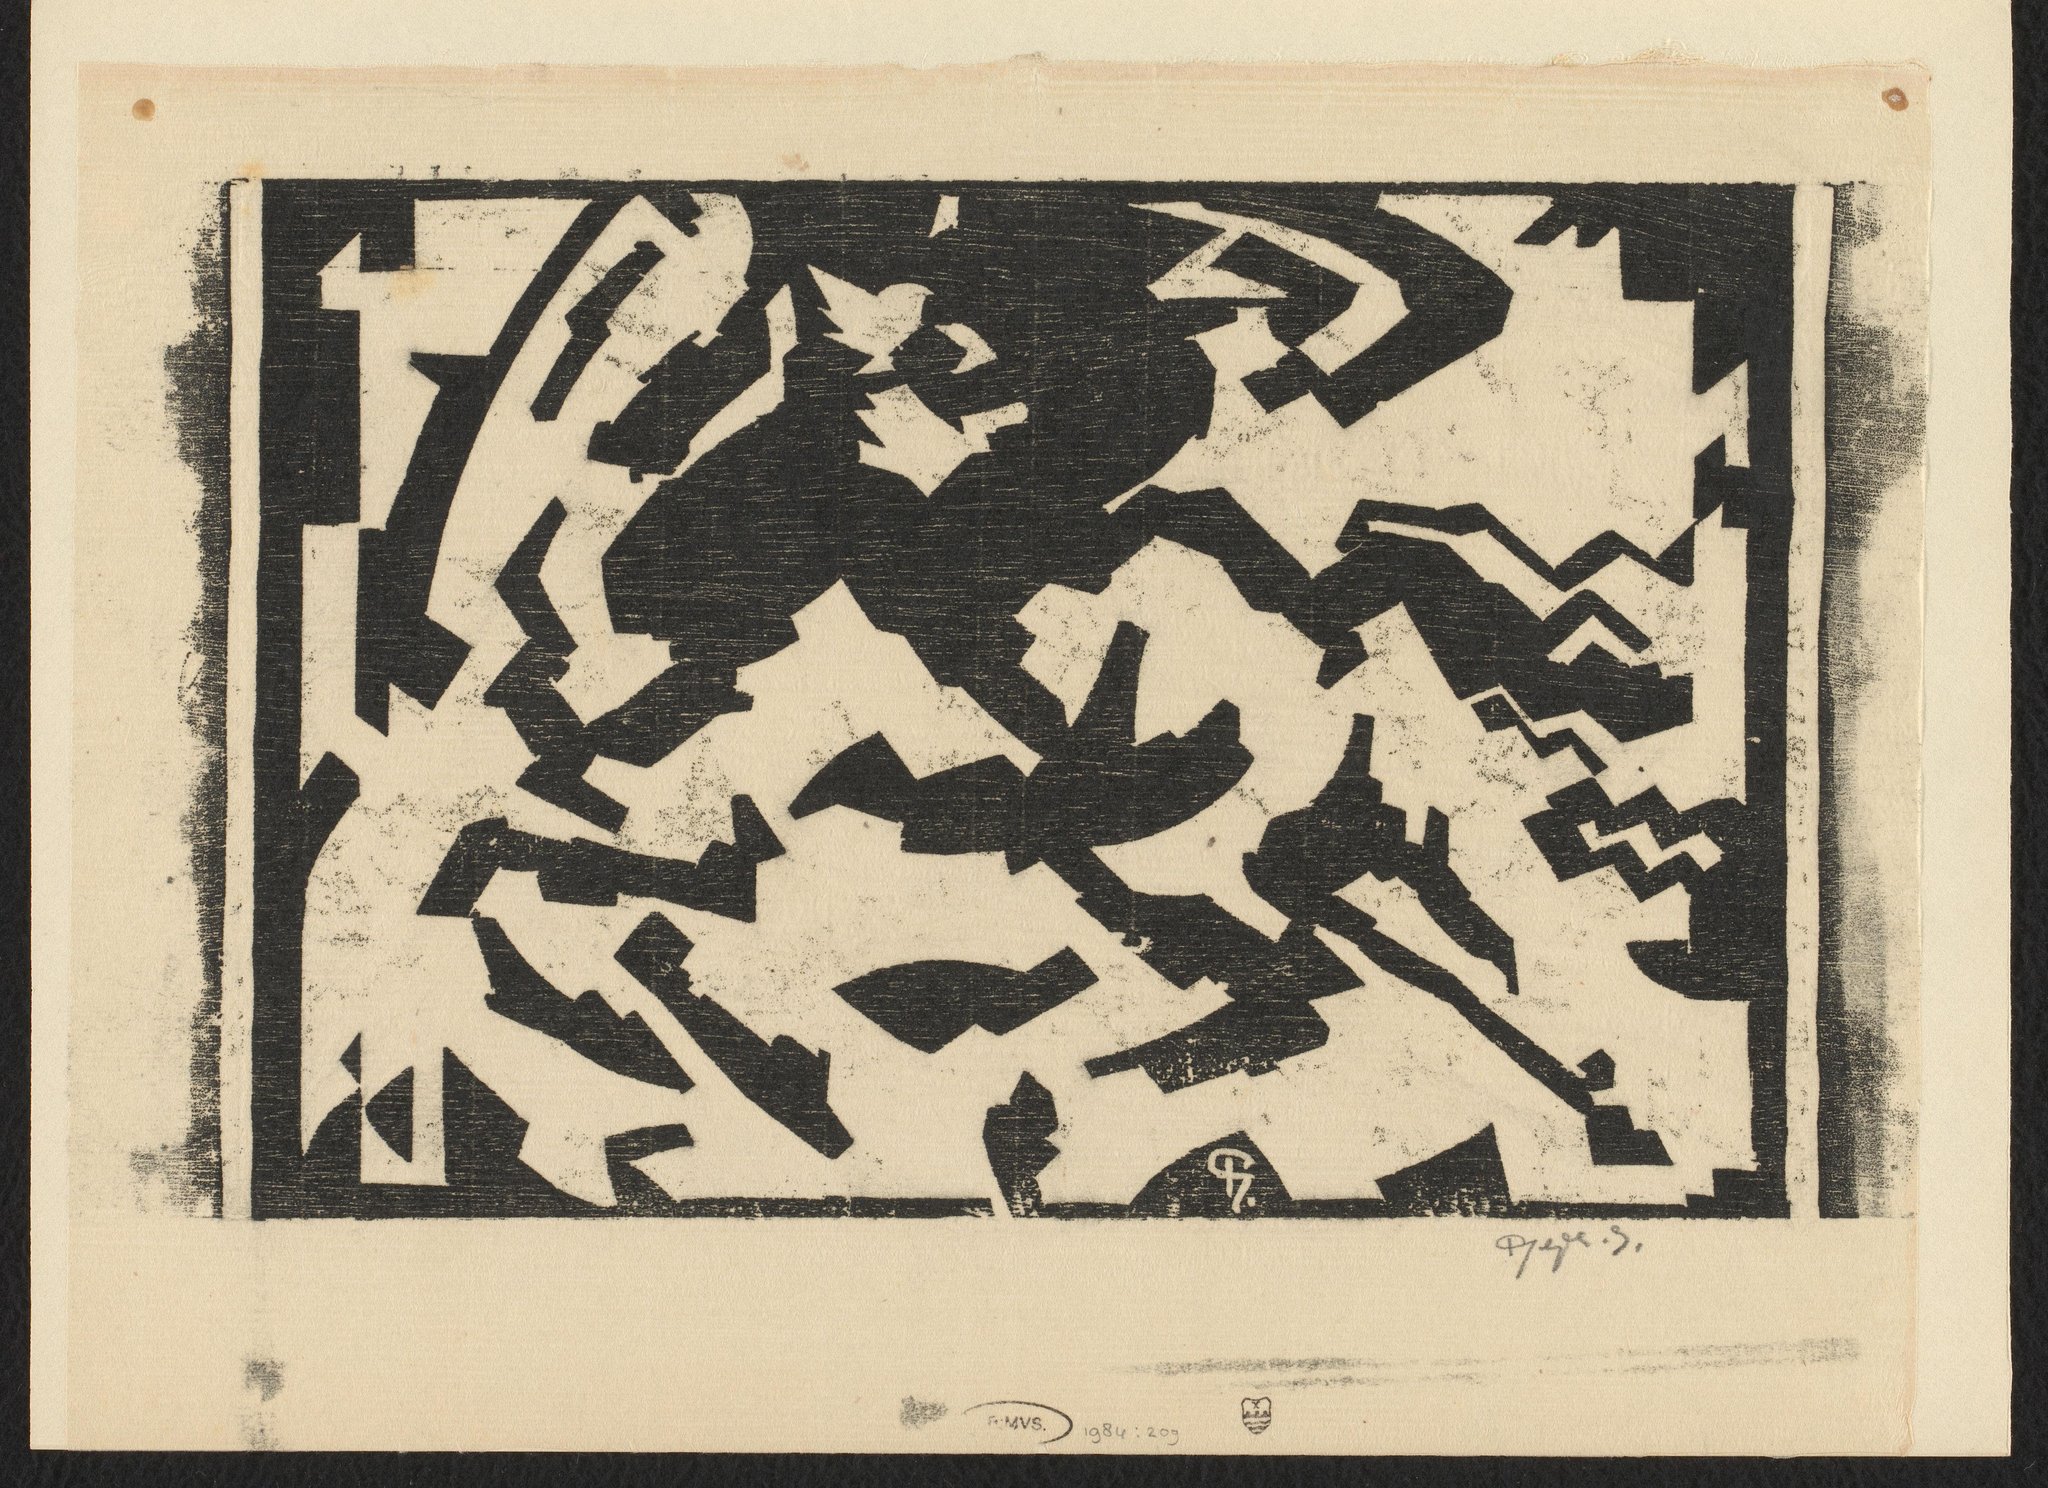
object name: print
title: Het paard, 6 studies in hout gesneden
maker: reijer stolk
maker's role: draughtsman, print maker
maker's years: 1896-1945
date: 1921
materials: paper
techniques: woodcut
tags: horses and kindred animals, hitching up, harnessing ~ animal traction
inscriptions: collector's mark: Lugt 2228, collector's mark: Lugt 2760